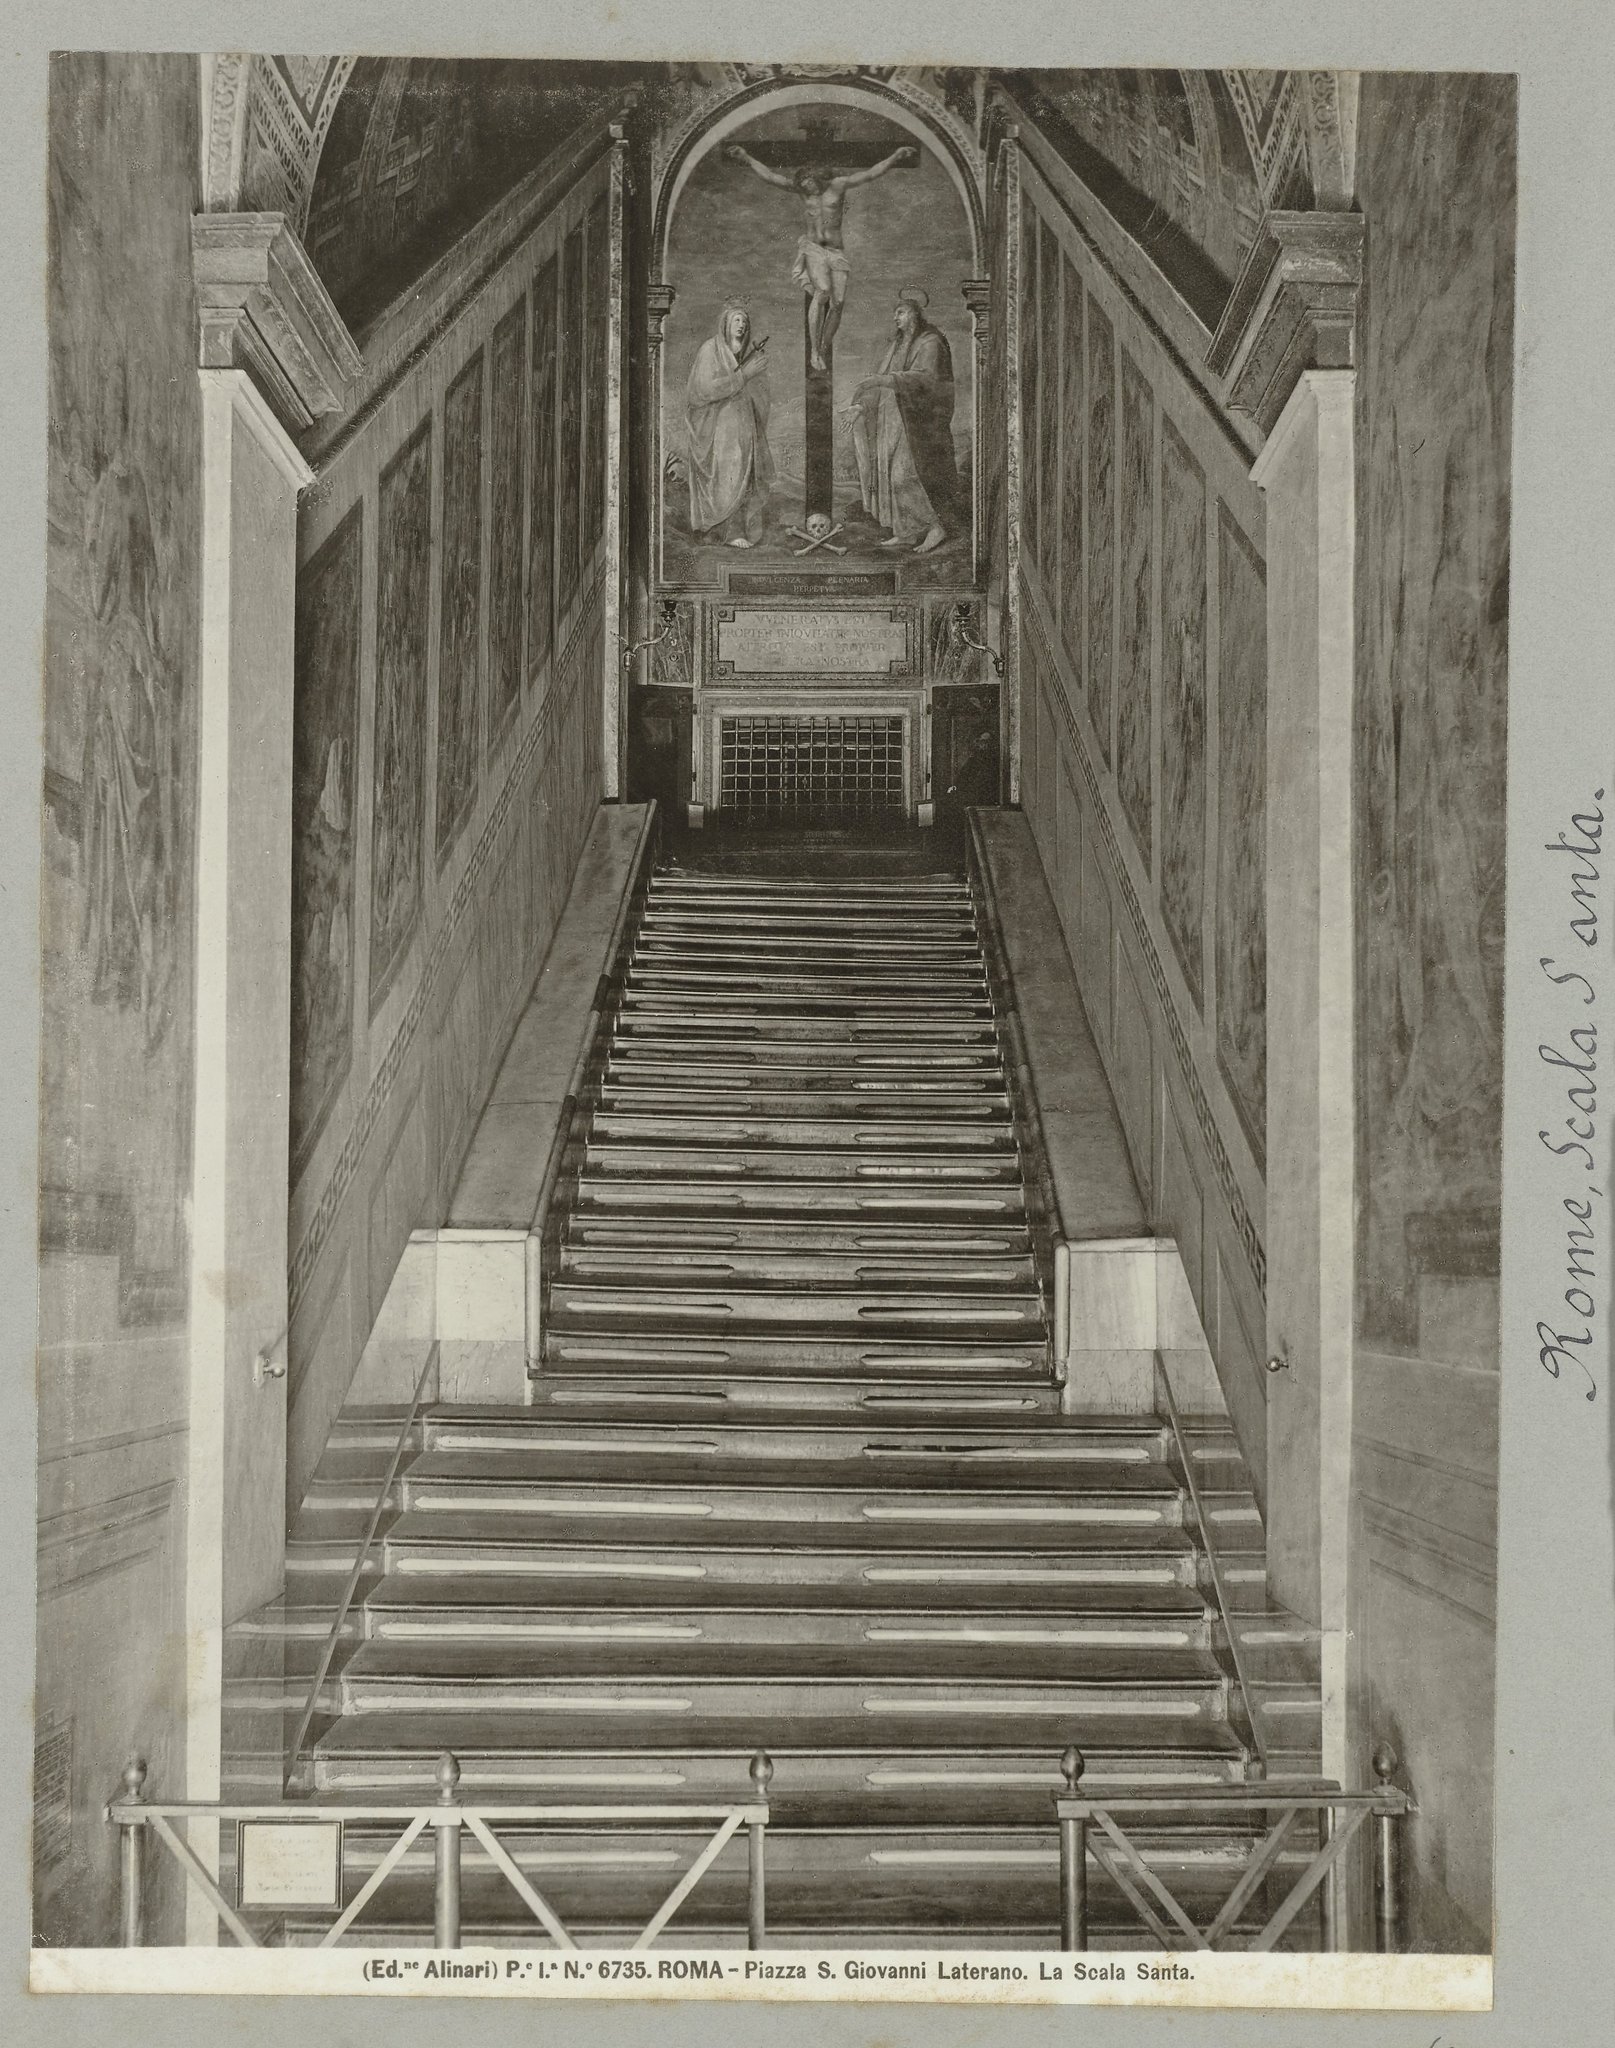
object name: photograph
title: Rome. Scala Santa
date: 1893-1903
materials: cardboard, photographic support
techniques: albumen print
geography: netherlands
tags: rome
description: De Heilige trap in het Oude Latraanse paleis met bovenaan de trap een schildering van Christus aan het kruis.